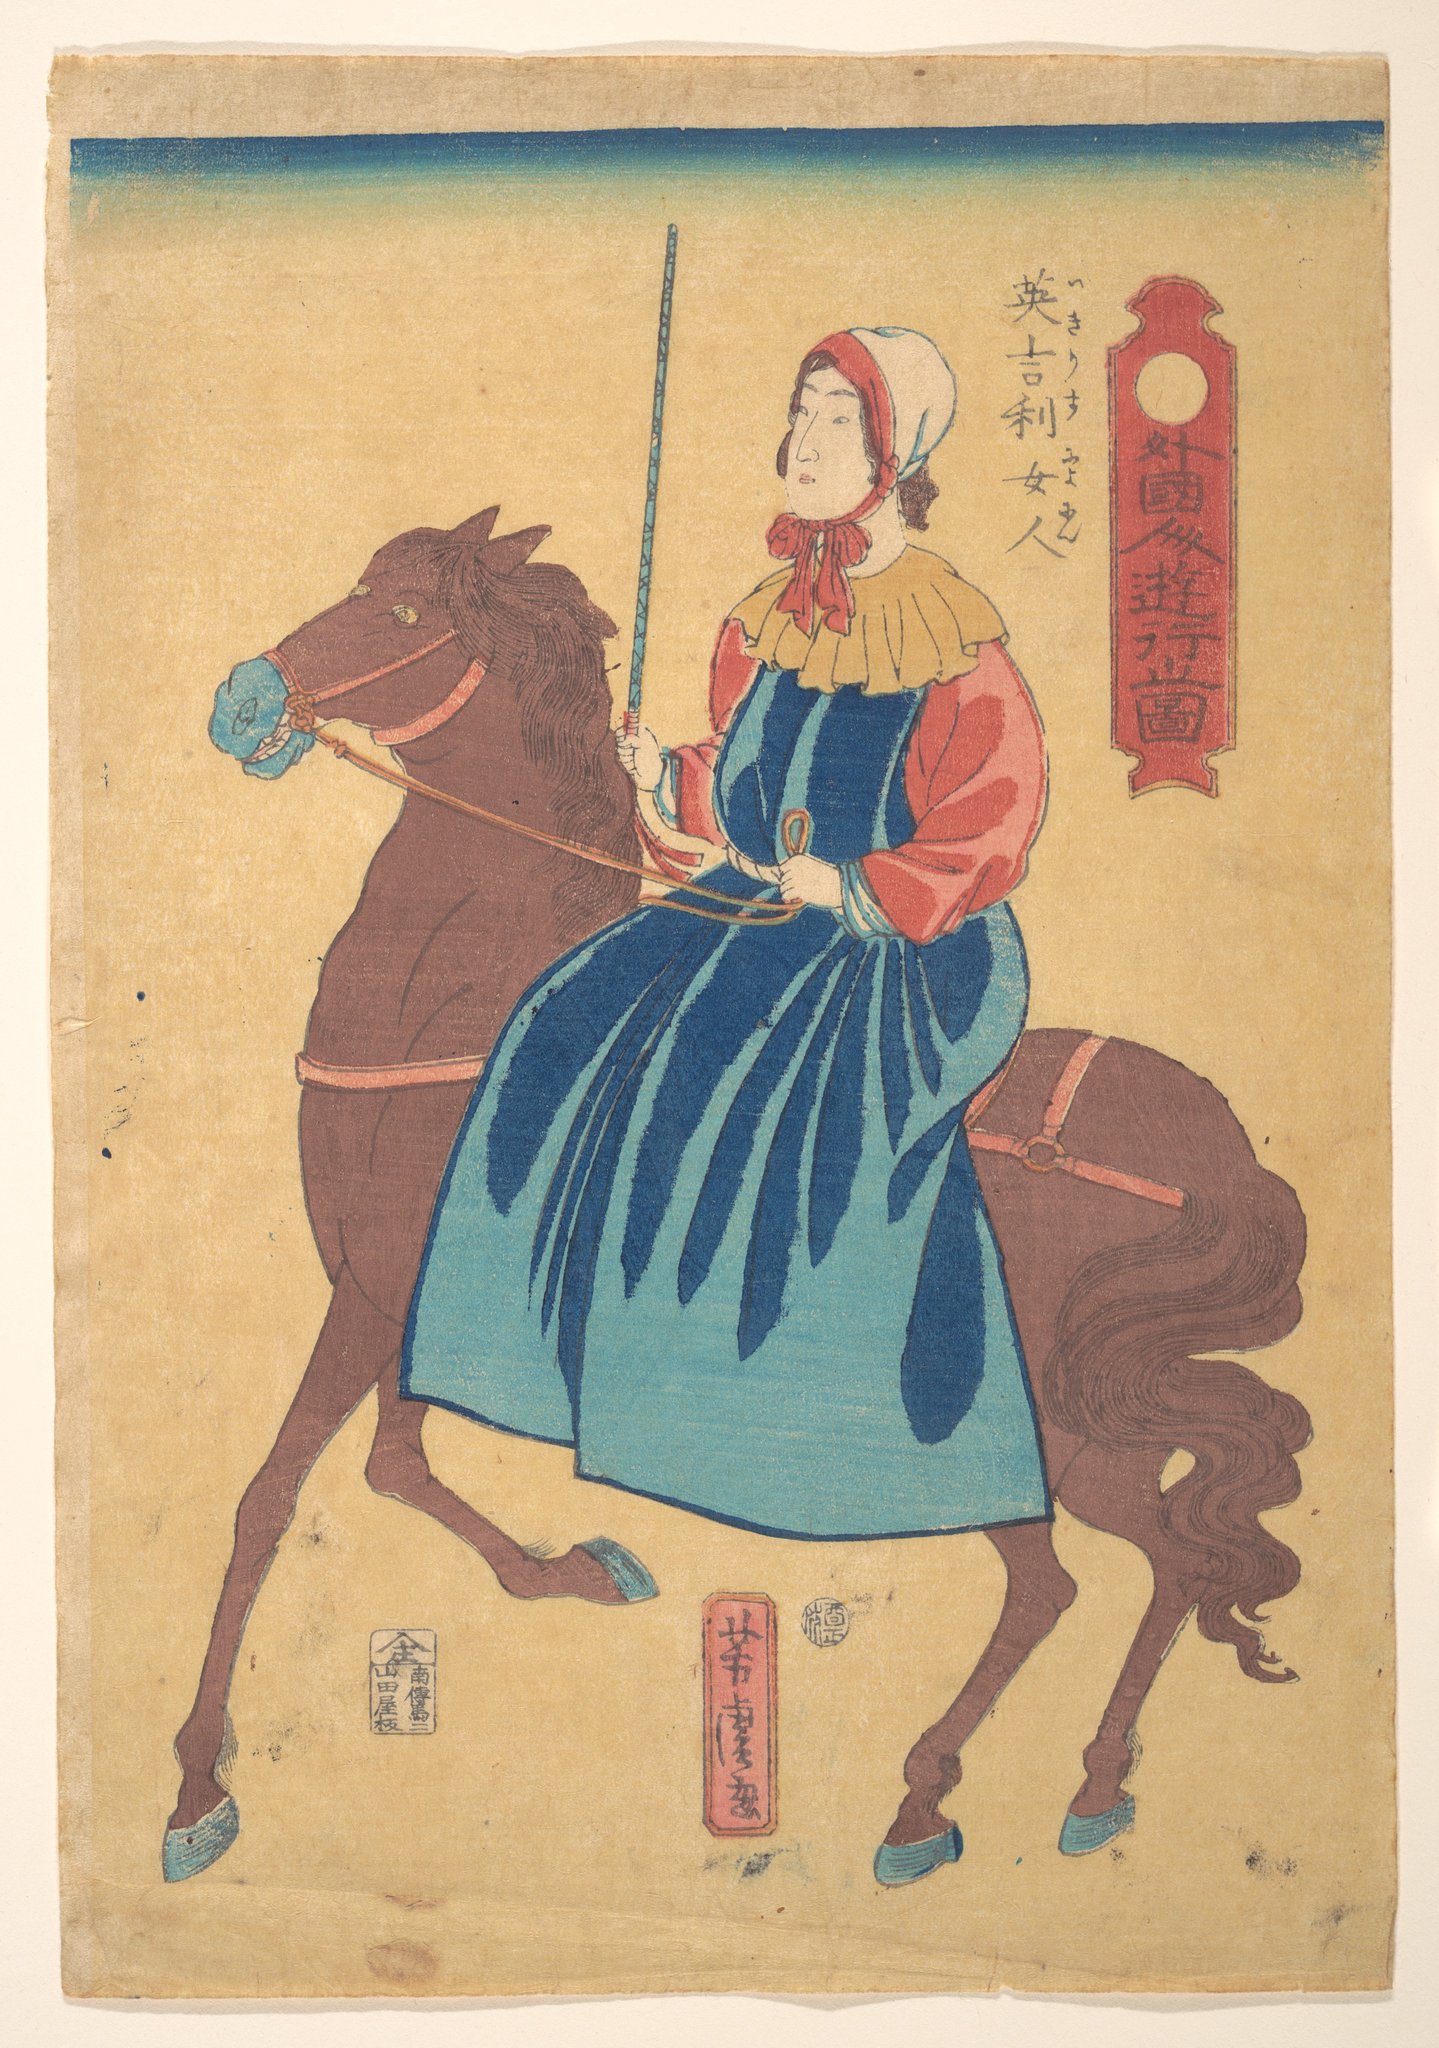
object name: woodblock print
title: Englishmen Woman on Horseback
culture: japanese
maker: utagawa yoshitora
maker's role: artist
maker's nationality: japanese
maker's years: 1845-1880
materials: ink, paper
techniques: woodblock print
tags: women,horses